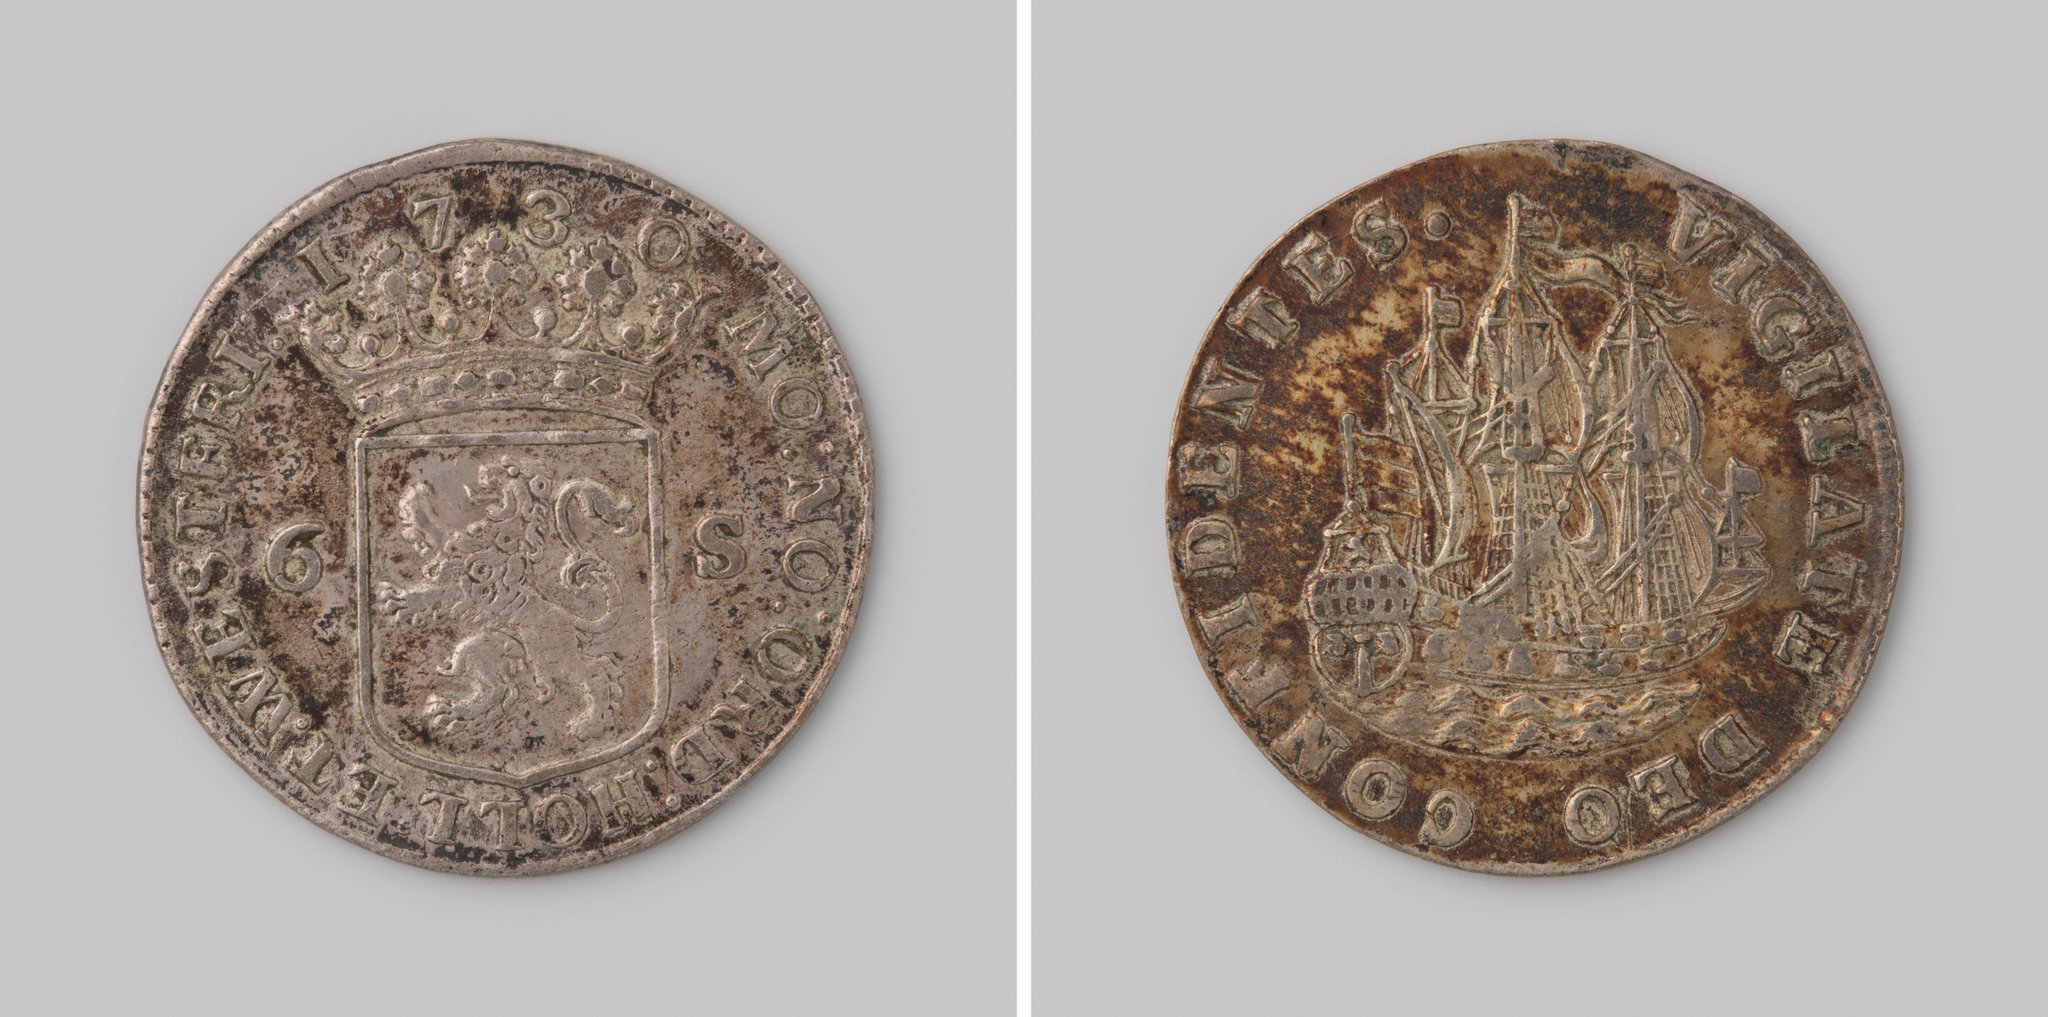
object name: coin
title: Holland, scheepjesschelling, 1730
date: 1730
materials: silver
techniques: striking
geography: dordrecht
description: Zilveren munt. Voorzijde: tussen waarde-aanduiding 6 S gekroond wapenschild van Holland. Jaartal boven kroon. In omschrift: HOLL[andiae] ET WESTFRI[siae]. Keerzijde: oorlogsschip, varend naar rechts.